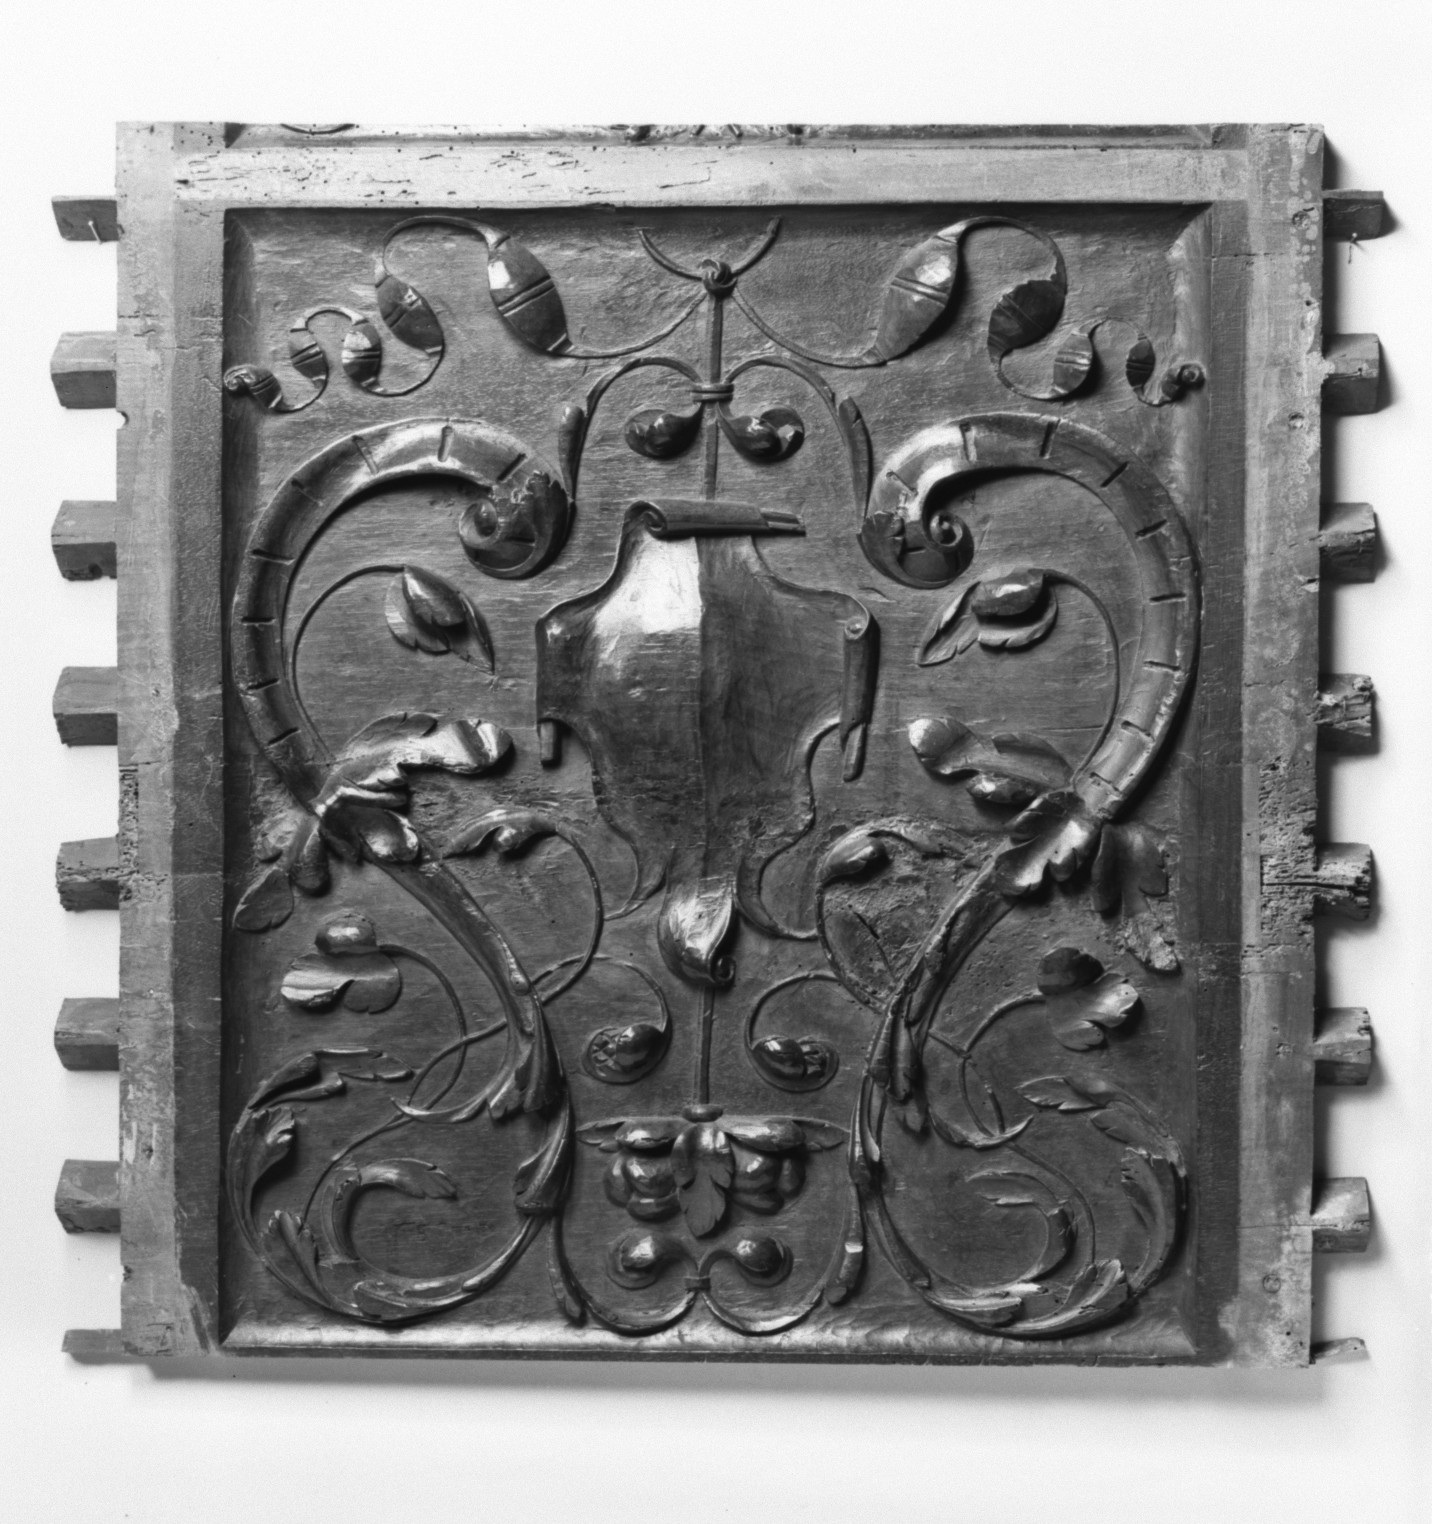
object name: panel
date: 1501-1600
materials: wood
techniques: carving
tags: leaves